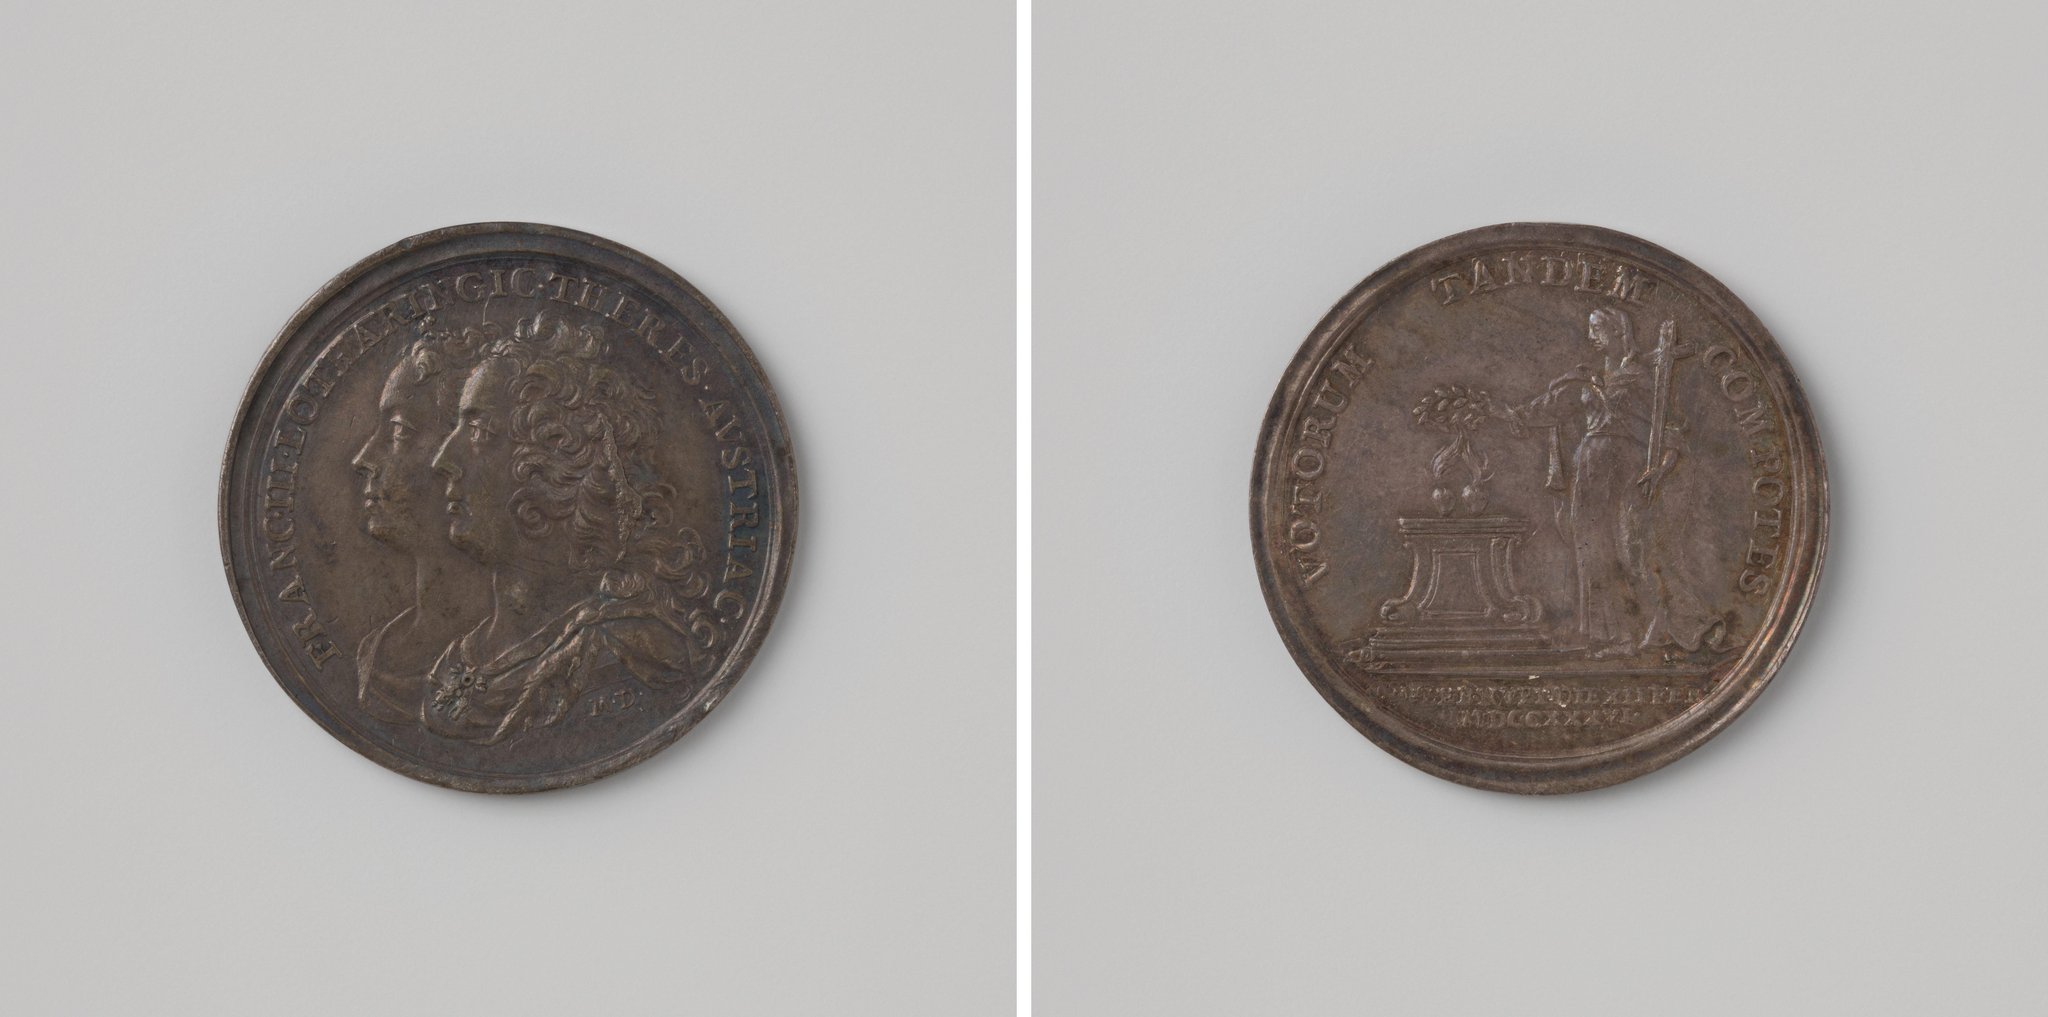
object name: history medal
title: Huwelijk van Frans Stephen, hertog van Lotharingen en Maria Theresia, aartshertogin van Oostenrijk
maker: matthäus donner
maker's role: sculptor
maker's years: 1704-1756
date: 1736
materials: silver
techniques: striking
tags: maria theresia (rooms-duits keizerin), frans i stefan (duits keizer)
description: Zilveren penning. Voorzijde: borststuk man en vrouw binnen omschrift. Keerzijde: Godsdienst met kruis in hand houdt krans boven twee brandende harten, die op altaar liggen binnen omschrift; afsnede: opschrift